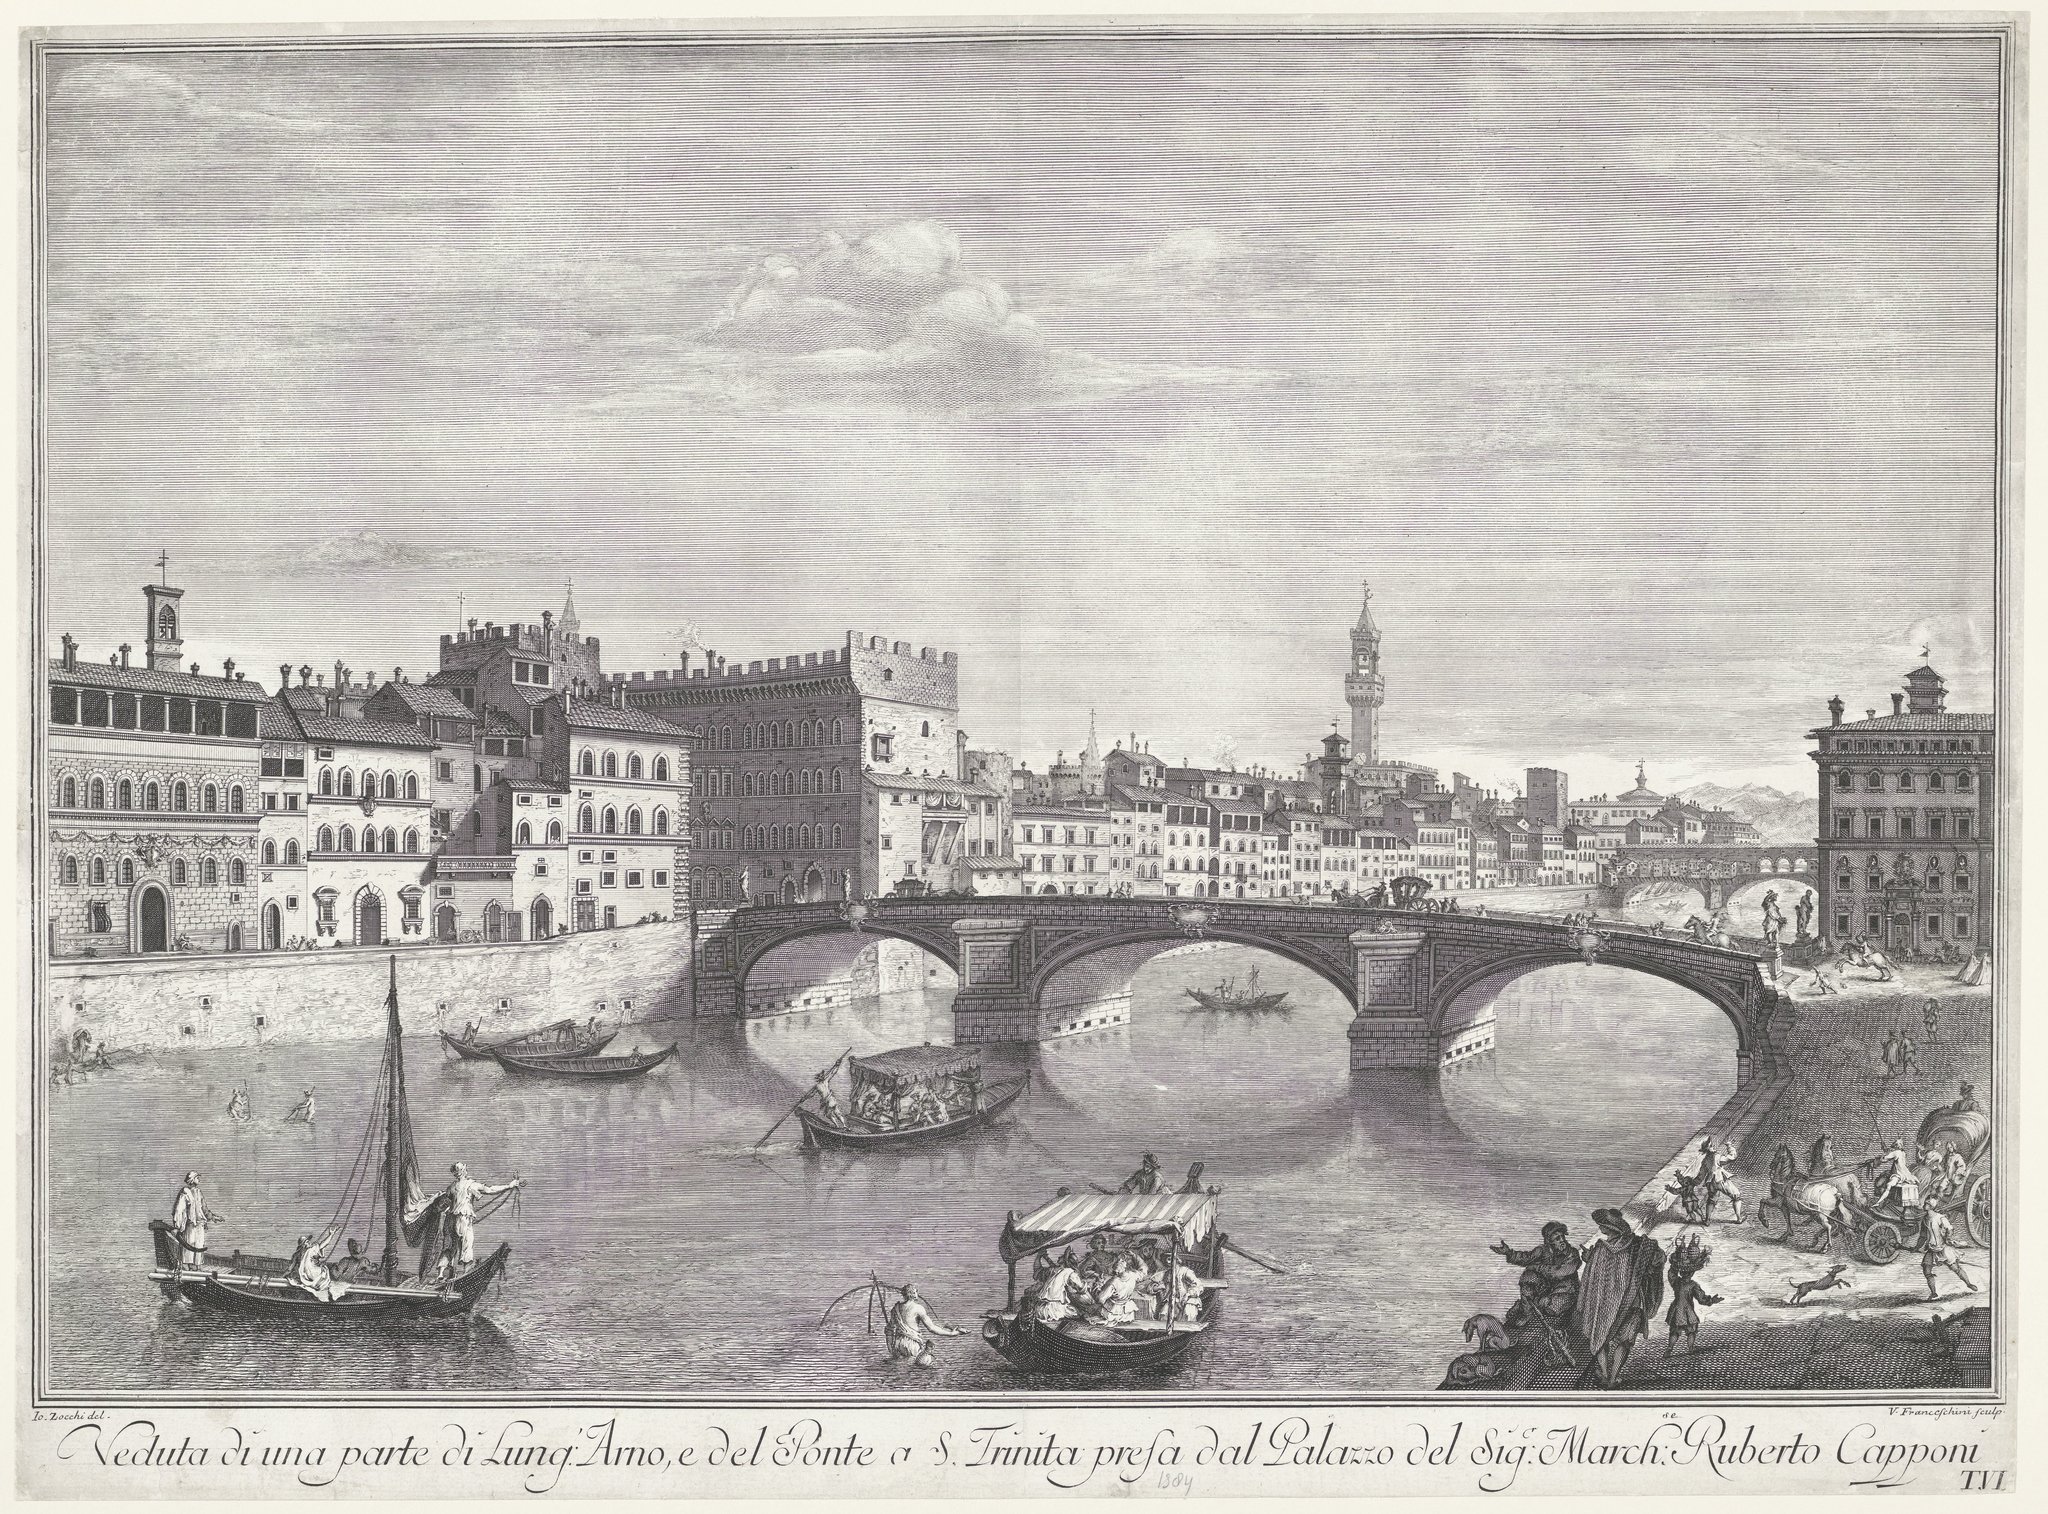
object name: print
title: Gezicht op de Arno te Florence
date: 1690-1750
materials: paper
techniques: engraving, etching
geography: italy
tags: city-view, and landscape with man-made constructions, river, bridge in city with structures, i.e. shops, houses, e.g. ponte vecchio in florence, bridge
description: Gezicht op de Arno te Florence. Rechts de Ponte Vecchio en de toren van Palazzo Vecchio. Op de voorgrond de Ponte Santa Trinita. Titel in ondermarge.